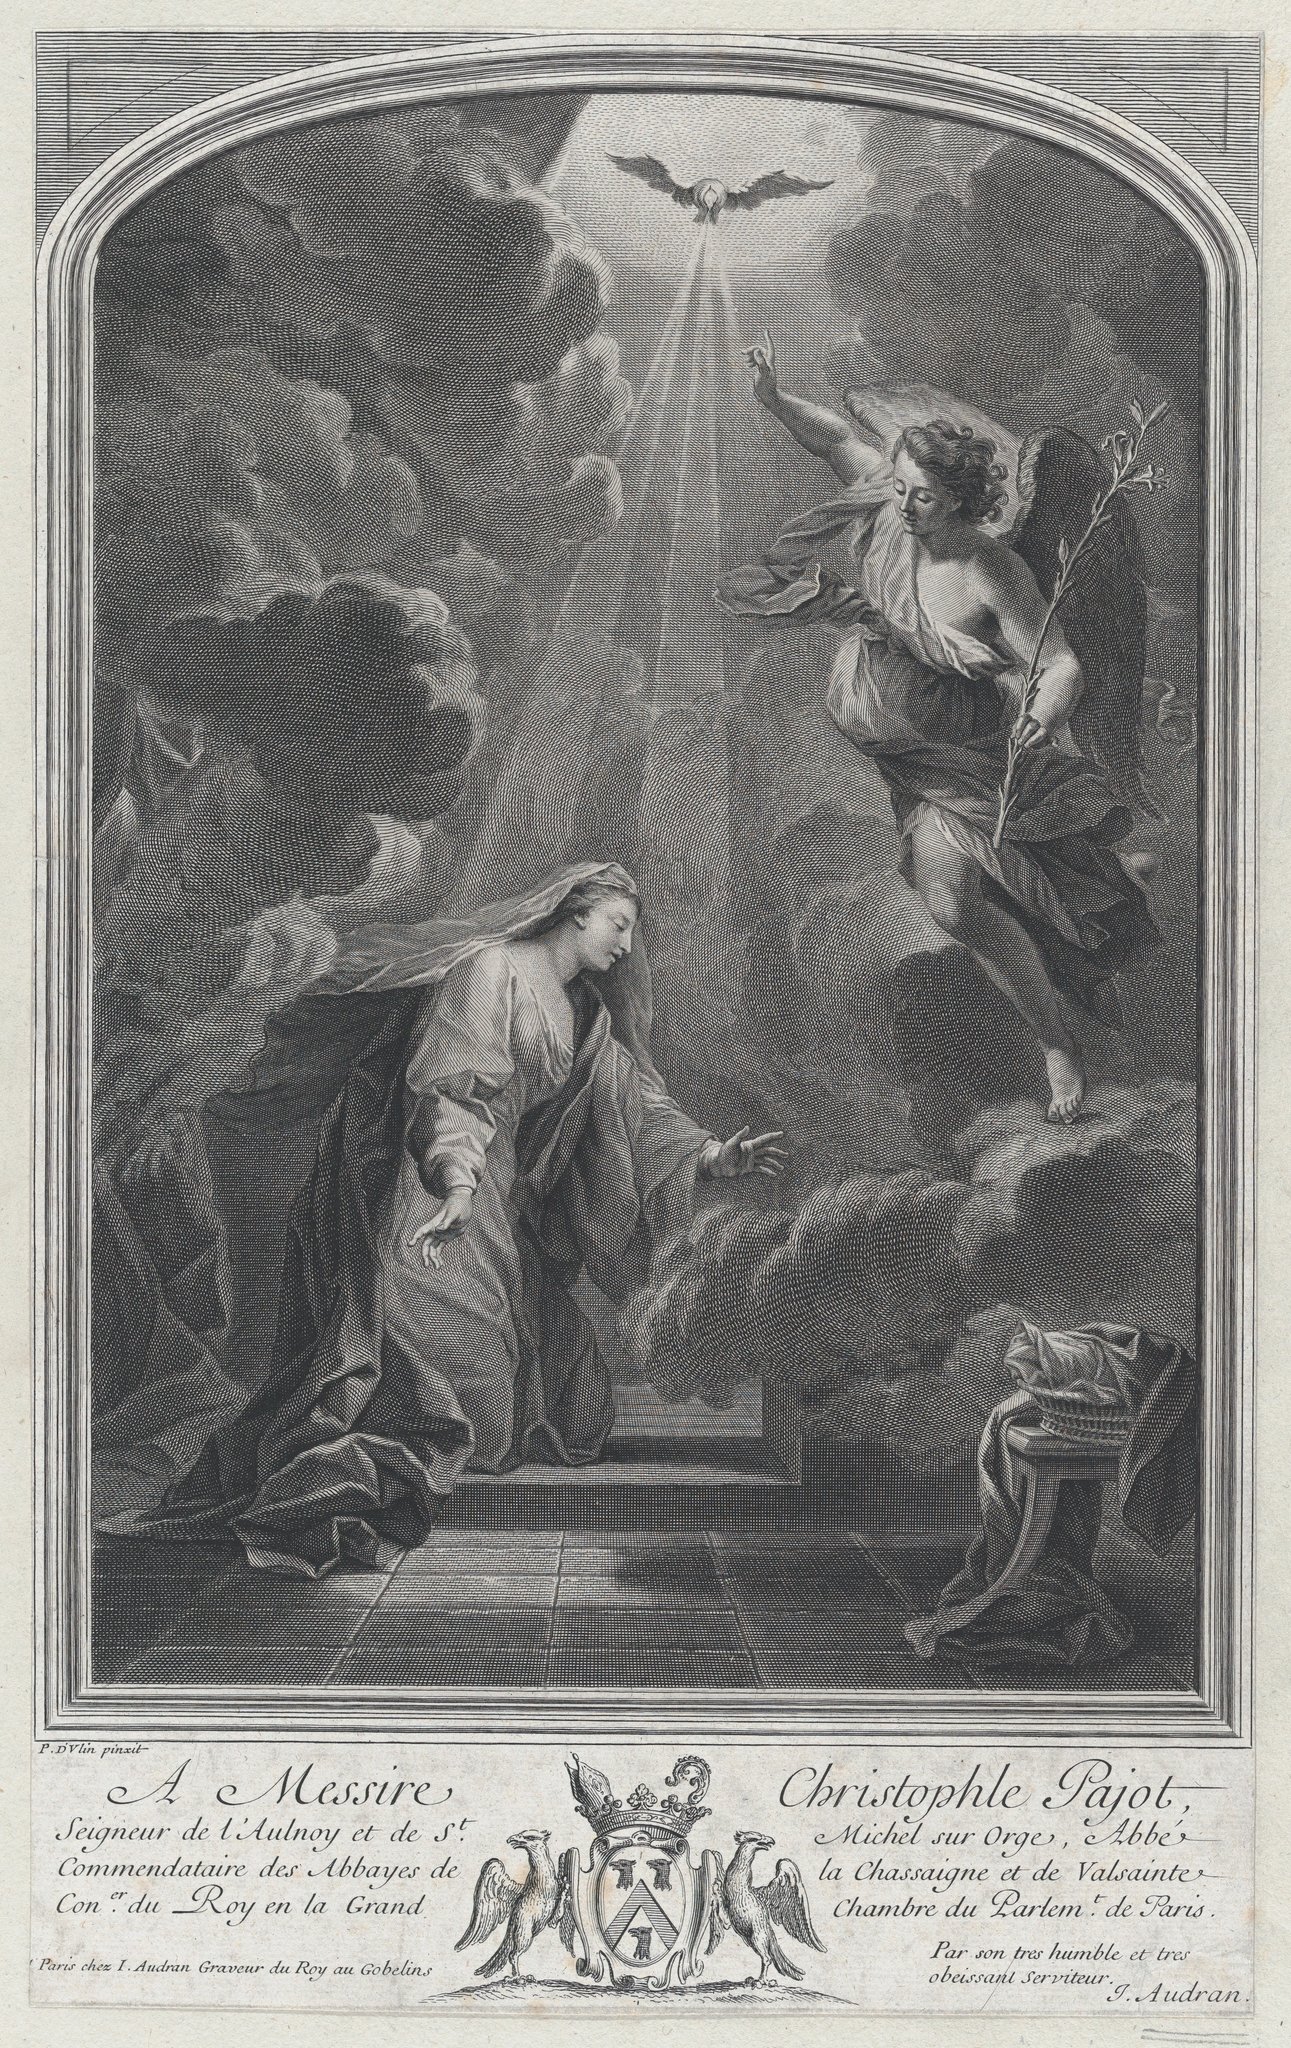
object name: print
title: The Annunciation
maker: jean audran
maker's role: artist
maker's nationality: french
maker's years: 1667-1756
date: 1700-1756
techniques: etching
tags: angels,virgin mary,annunciation,coat of arms